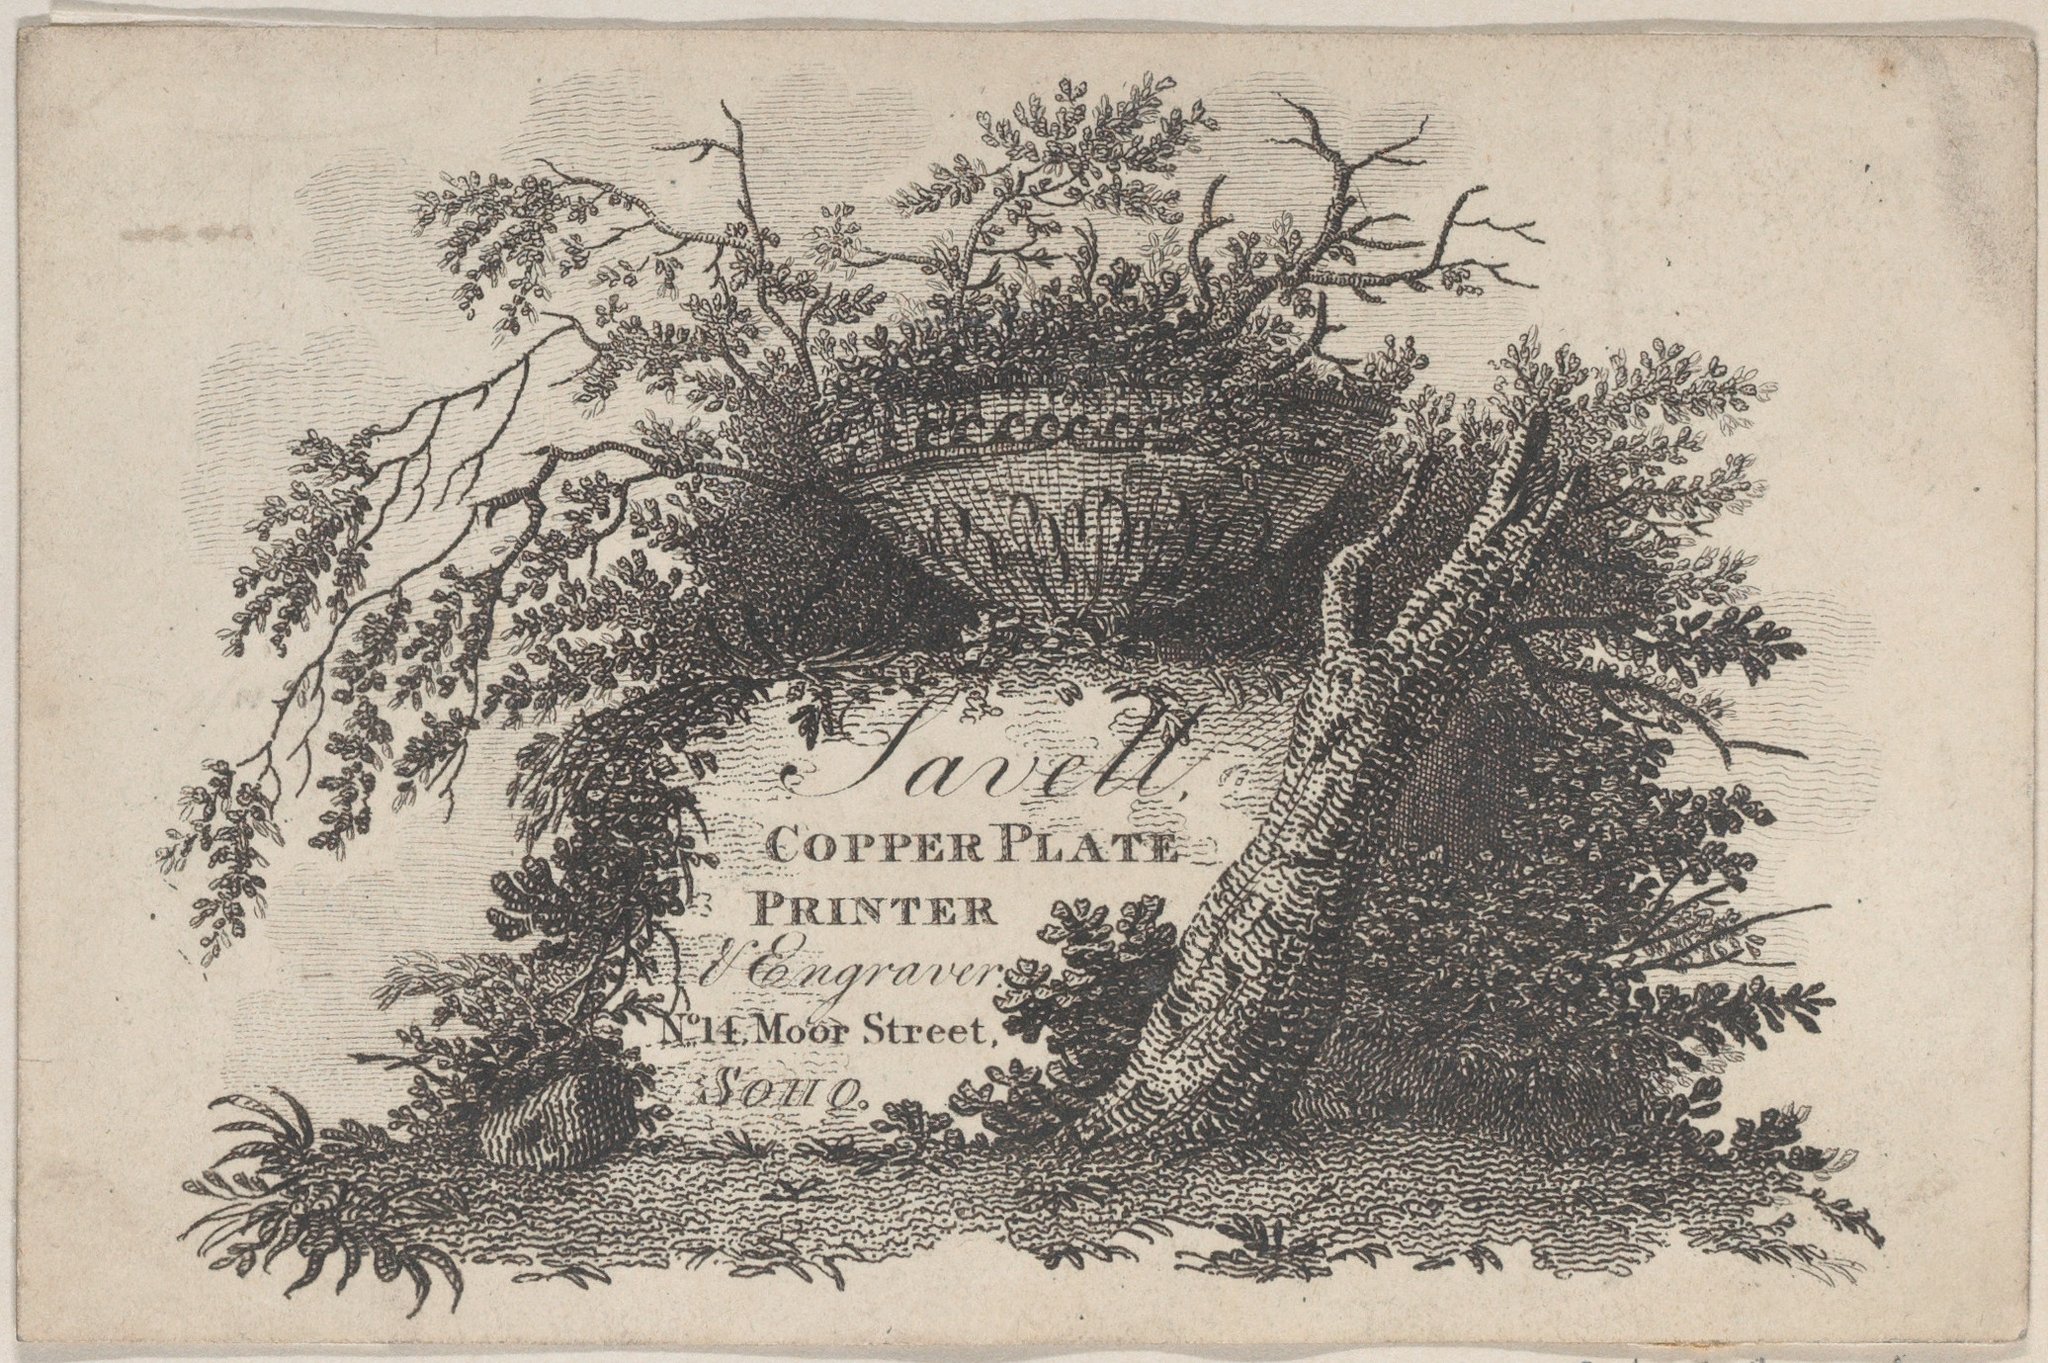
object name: print, trade card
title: Trade Card for Savell, Copper Plate Printer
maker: anonymous, british, 18th century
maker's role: artist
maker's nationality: british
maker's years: 1700-1800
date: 1701-1800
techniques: engraving